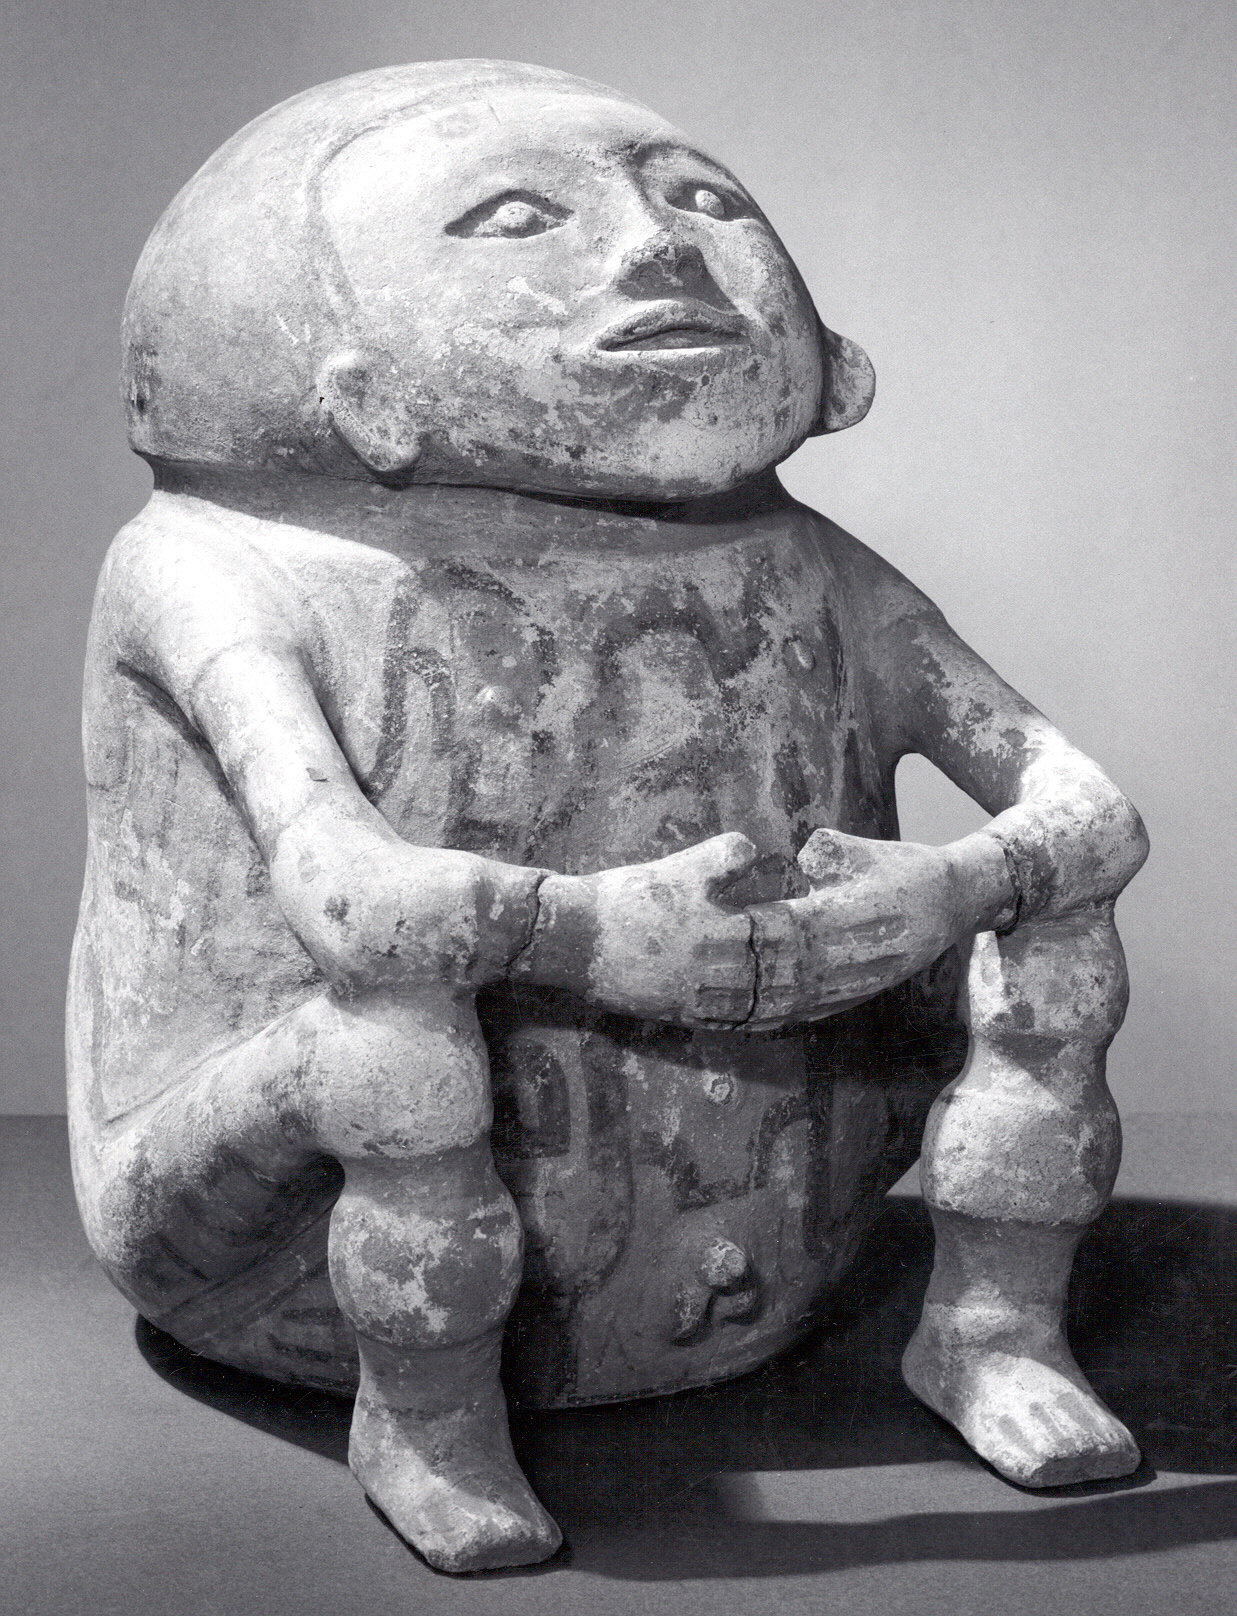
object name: vessel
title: Ceramic Vessel in the Form of a Seated Man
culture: rio napo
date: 501-1300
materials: ceramic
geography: ecuador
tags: men